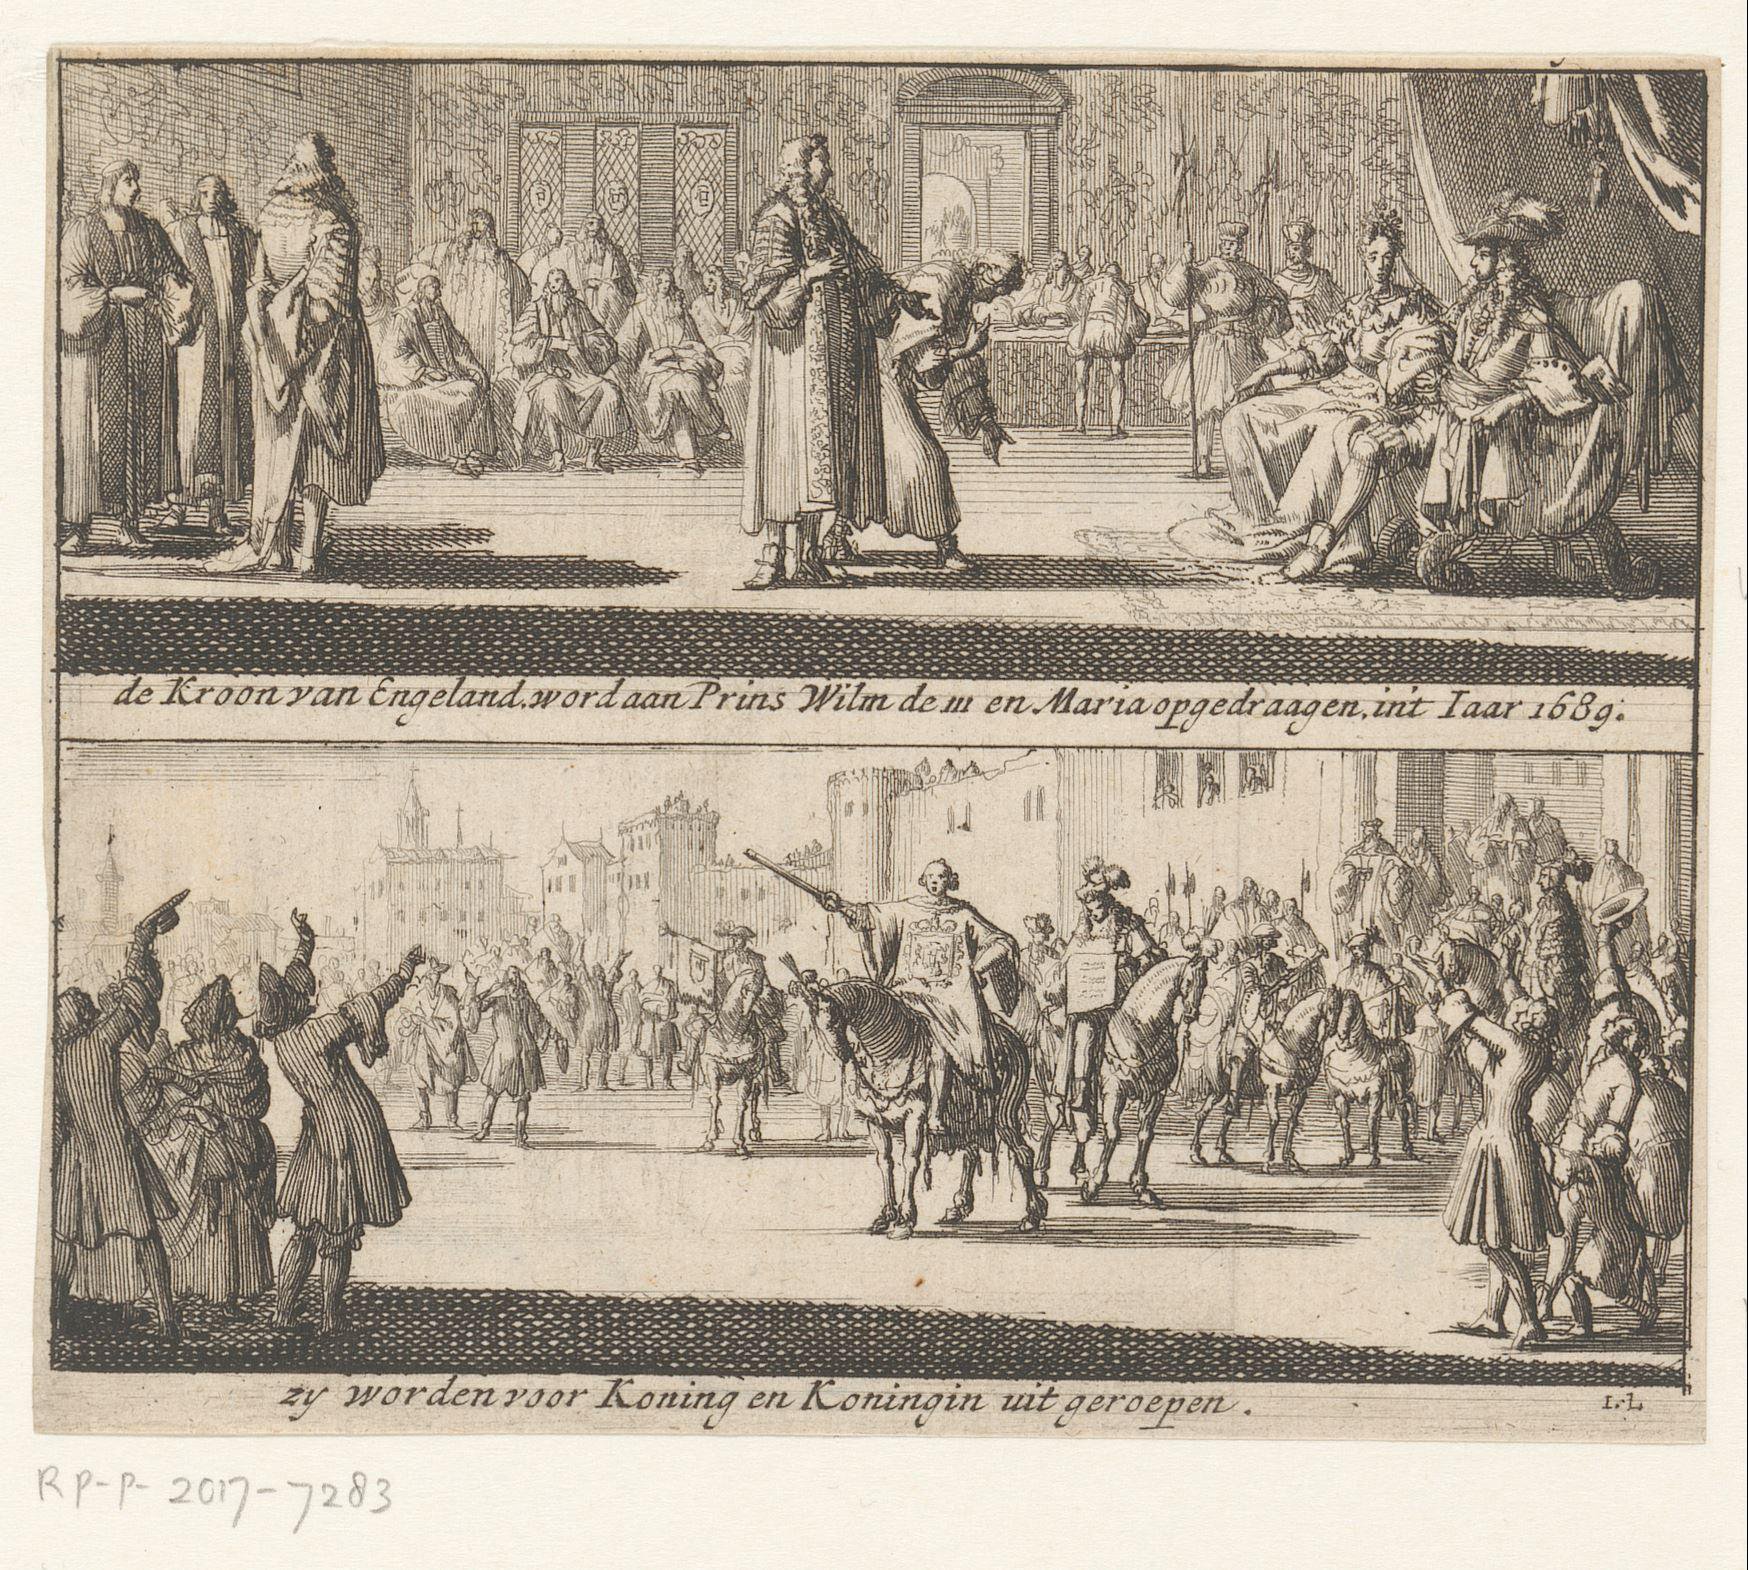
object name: print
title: de Kroon van Engeland, word aan Prins Wilm de III en Maria opgedraagen, in't Jaar 1689 / zy worden voor Koning en Koningin uit geroepen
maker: jan luyken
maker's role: draughtsman, print maker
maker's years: 1649-1712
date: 1689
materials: paper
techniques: etching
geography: northern netherlands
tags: william iii (prince of orange and king of england, scotland, and ireland), maria ii stuart (koningin van engeland, schotland en ierland), crier (~ proclamation of laws), oral spreading of news, town crier, london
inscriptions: collector's mark: Lugt 2228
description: Illustratie uit: Pers, Dirck Pietersz. Romeynschen adelaer, waer in de loffelĳcke en lasterlĳcke daden der Romeynsche koningen, en keyseren, verhandelt werden, 3 delen. Utrecht: Jurriaen van Poolsum, 1689, fol. 897. Deze prent is ook genummerd FMH 2696 als illustratie voor: Lambert van den Bosch, Het leven en bedryf van Willem de Darde, Jan Claesz ten Hoorn, Amsterdam 1694, 4 delen.